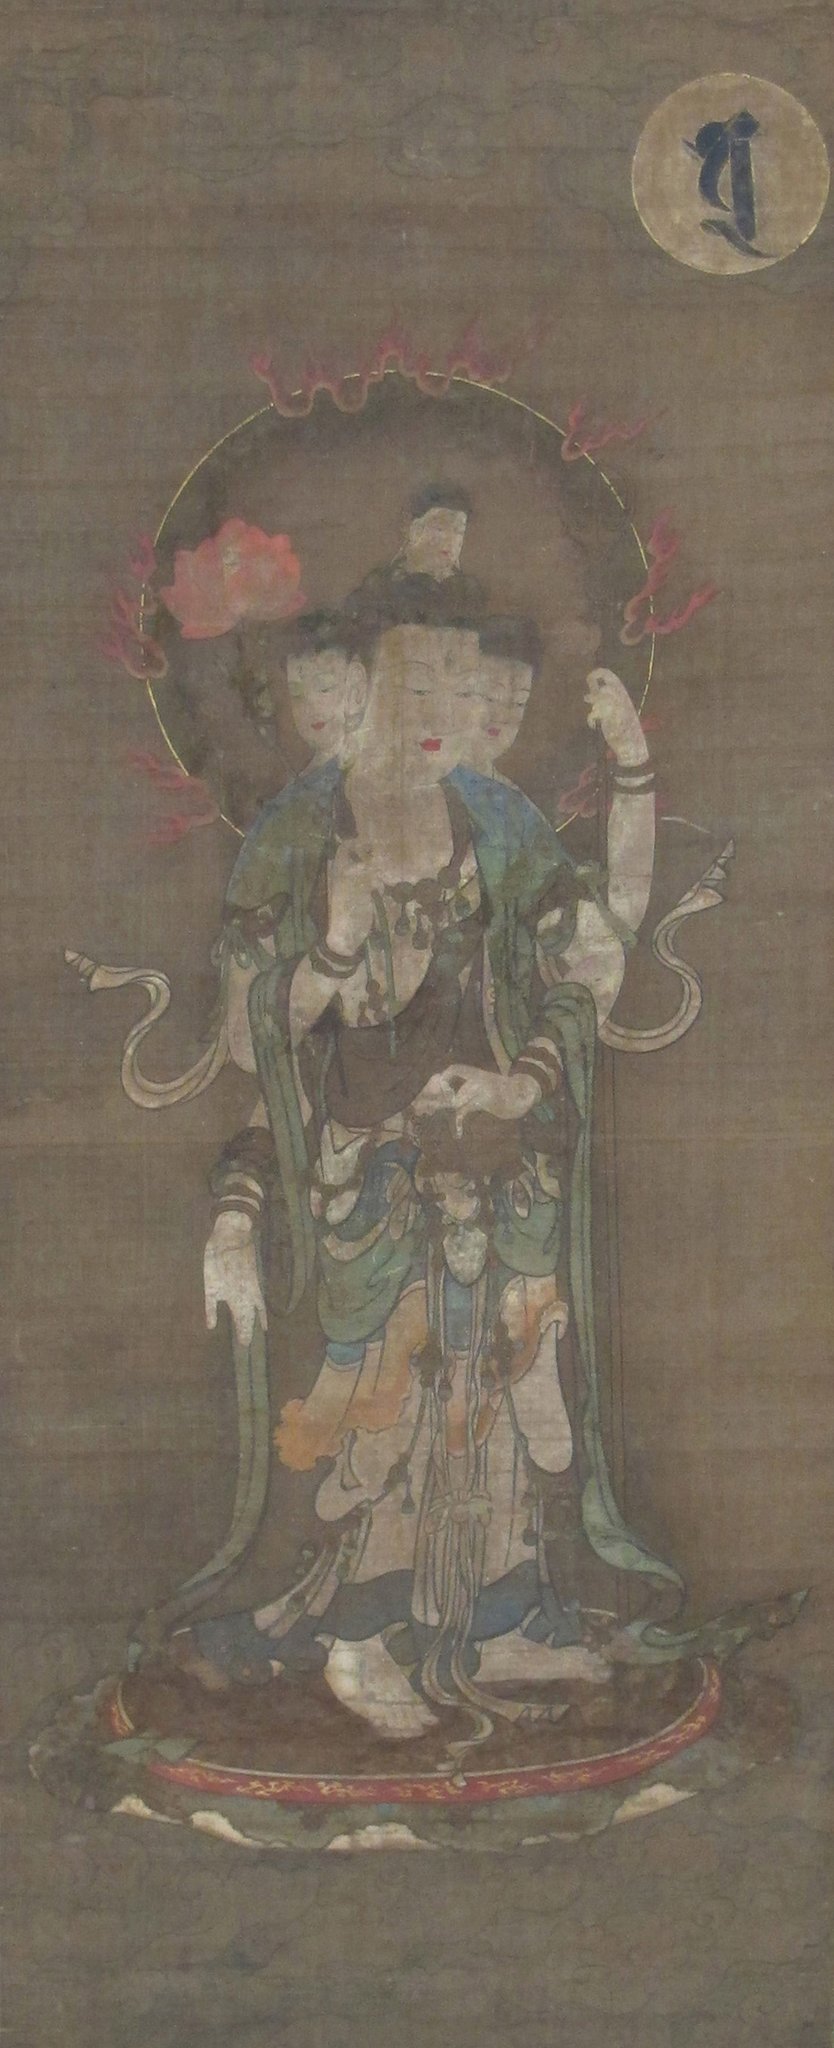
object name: painting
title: One of the Twelve Celestial Guardians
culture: japanese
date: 1351-1400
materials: gold, ink, panel, silk